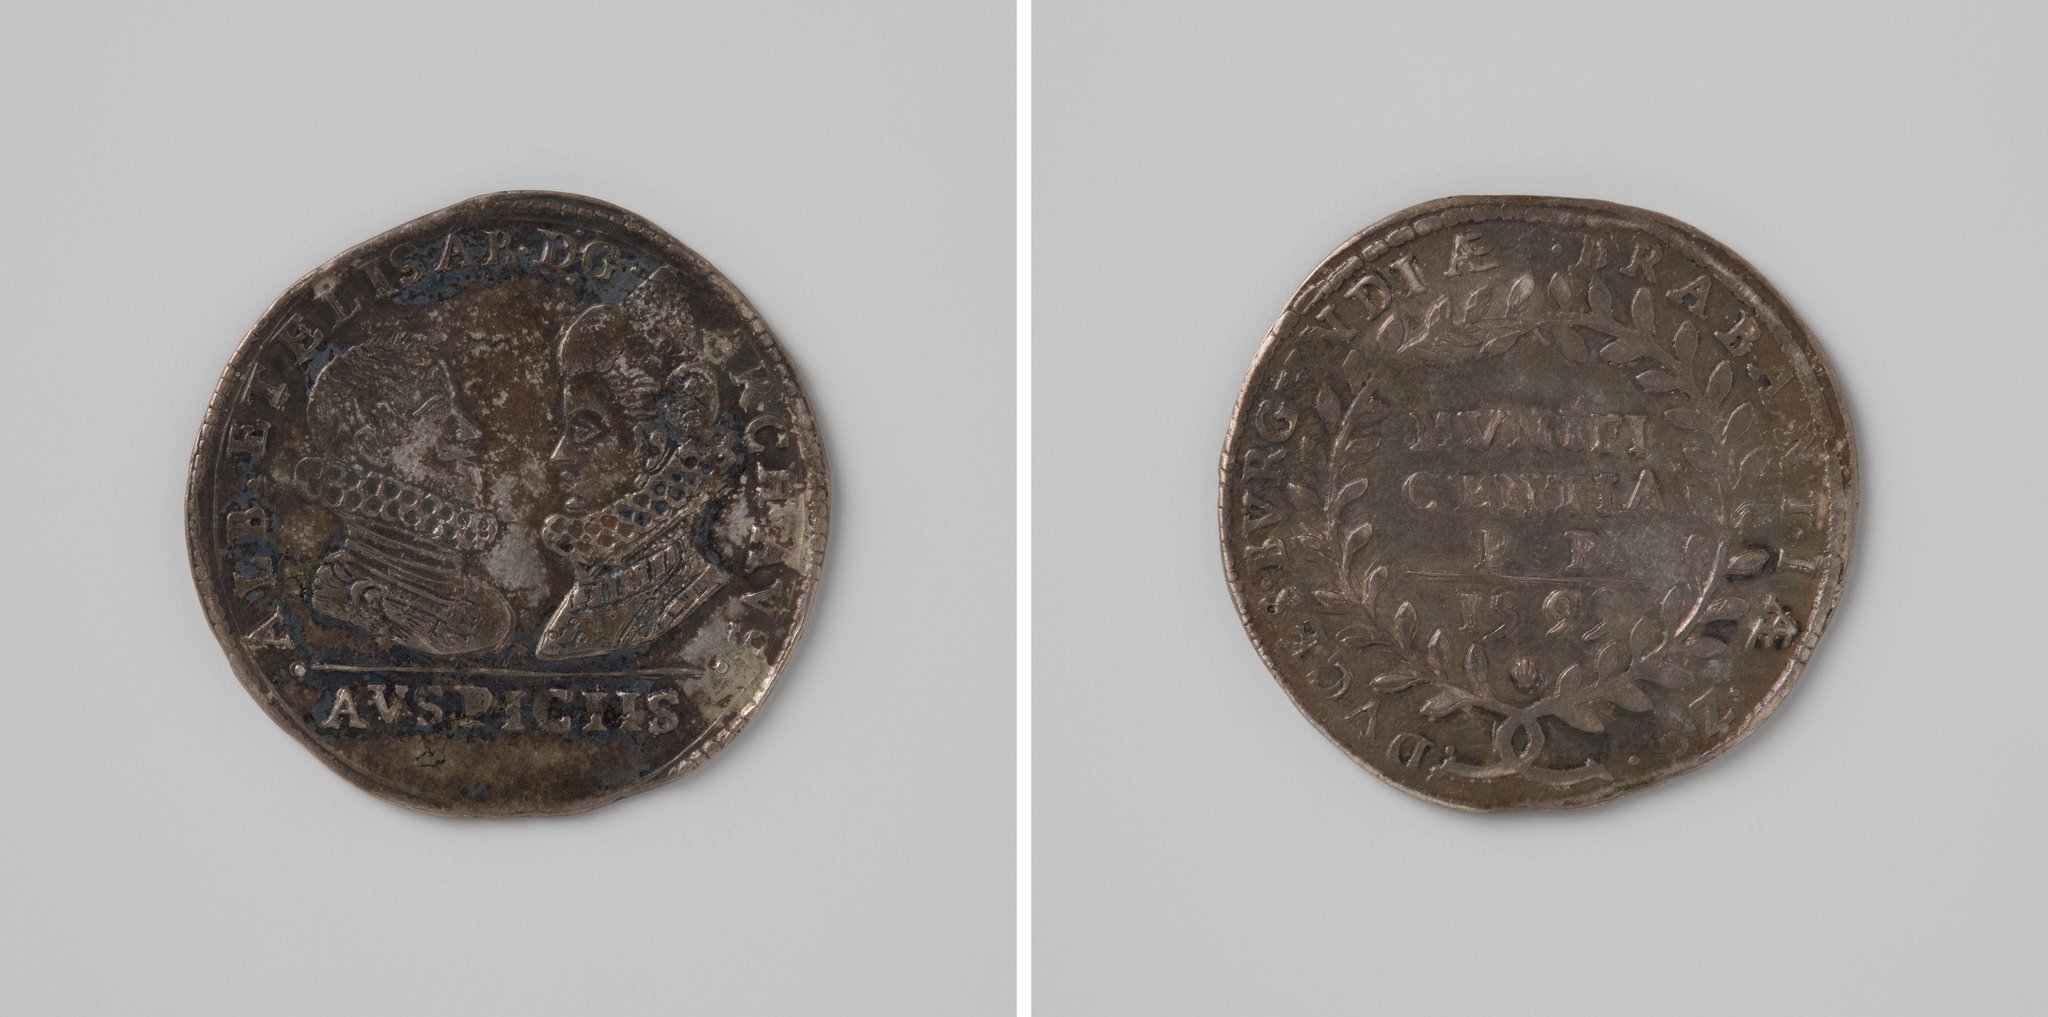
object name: strooipenning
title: De inkomst van Albertus en Isabella te Leuven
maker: Anonymous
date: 1599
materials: silver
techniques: striking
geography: southern netherlands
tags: infante van spanje isabella clara eugenia, brussels, albrecht aartshertog van oostenrijk, louvain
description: Zilveren penning. Voorzijde: borststukken man en vrouw, naar elkaar gekeerd binnen omschrift. Keerzijde: opschrift binnen lauwerkrans.